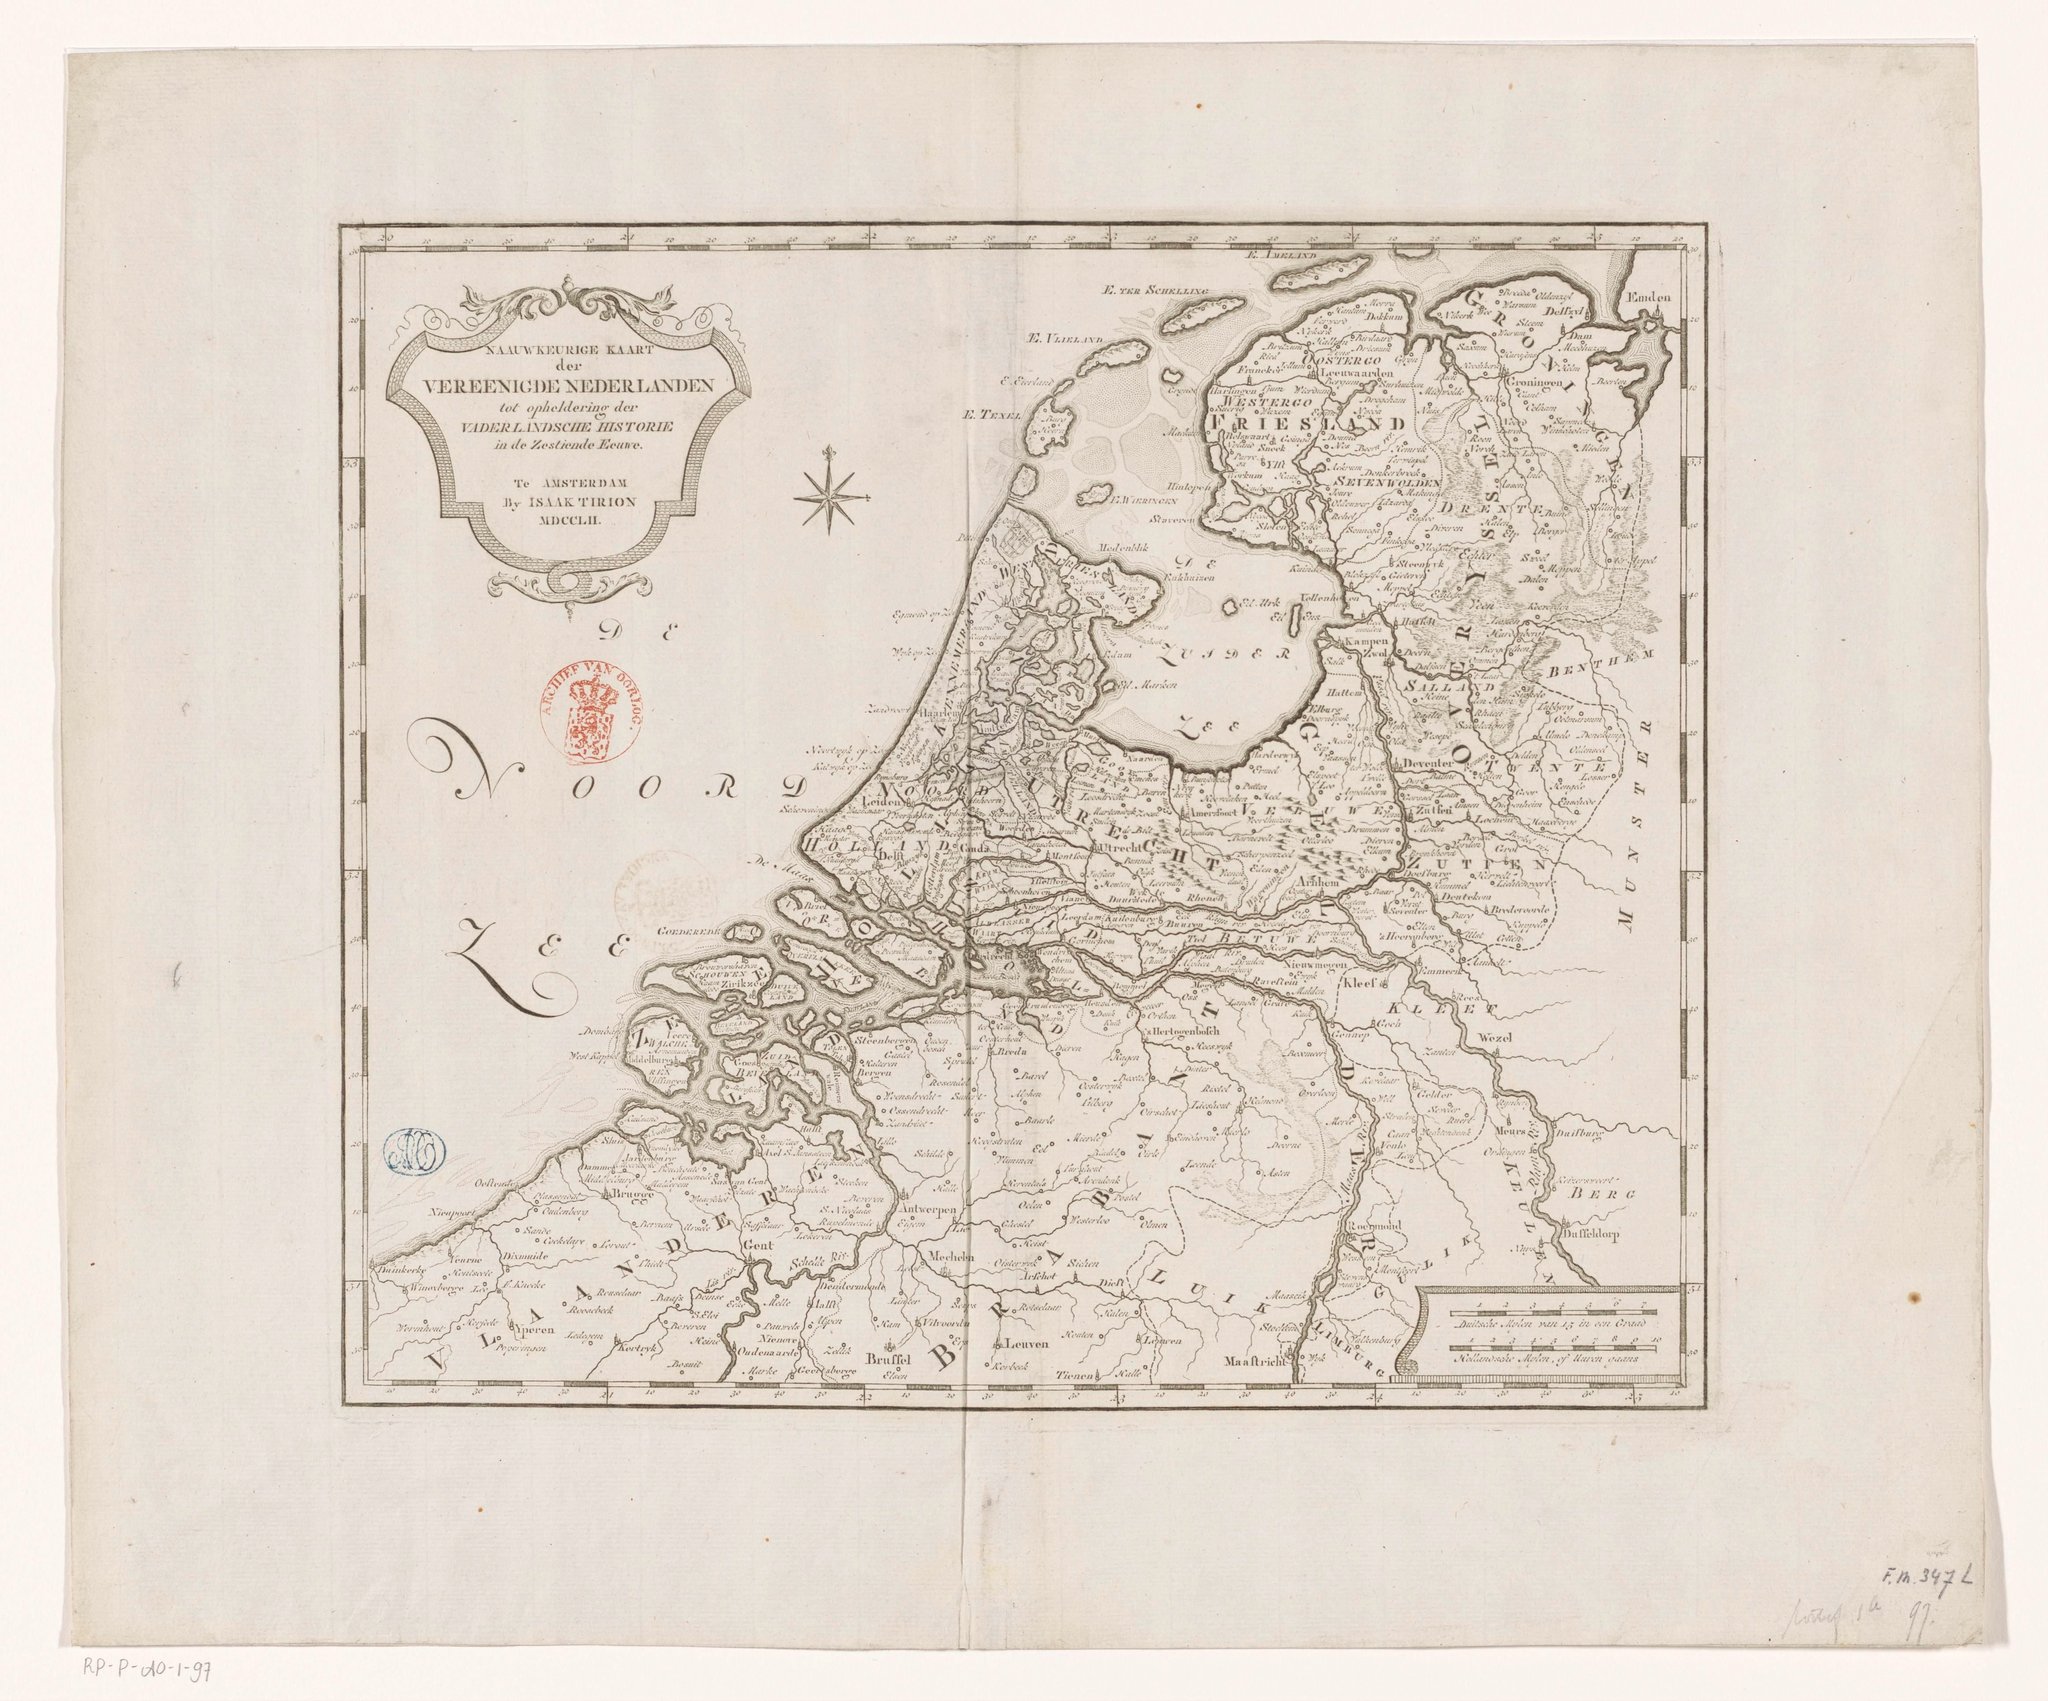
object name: map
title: Historische kaart van Nederland in de tweede helft van de zestiende eeuw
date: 1752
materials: paper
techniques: engraving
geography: amsterdam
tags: maps of separate countries or regions, netherlands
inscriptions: collector's mark: Lugt 195, collector's mark: Lugt 2228, collector's mark: Lugt 19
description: Achttiende-eeuwse kaart van Nederland in de tweede helft van de zestiende eeuw. Links titelcartouche. Rechts schaalstok: Duitsche mylen van 15 in een graad, Hollandsche mylen of uuren gaans. Gradenverdeling langs de randen.